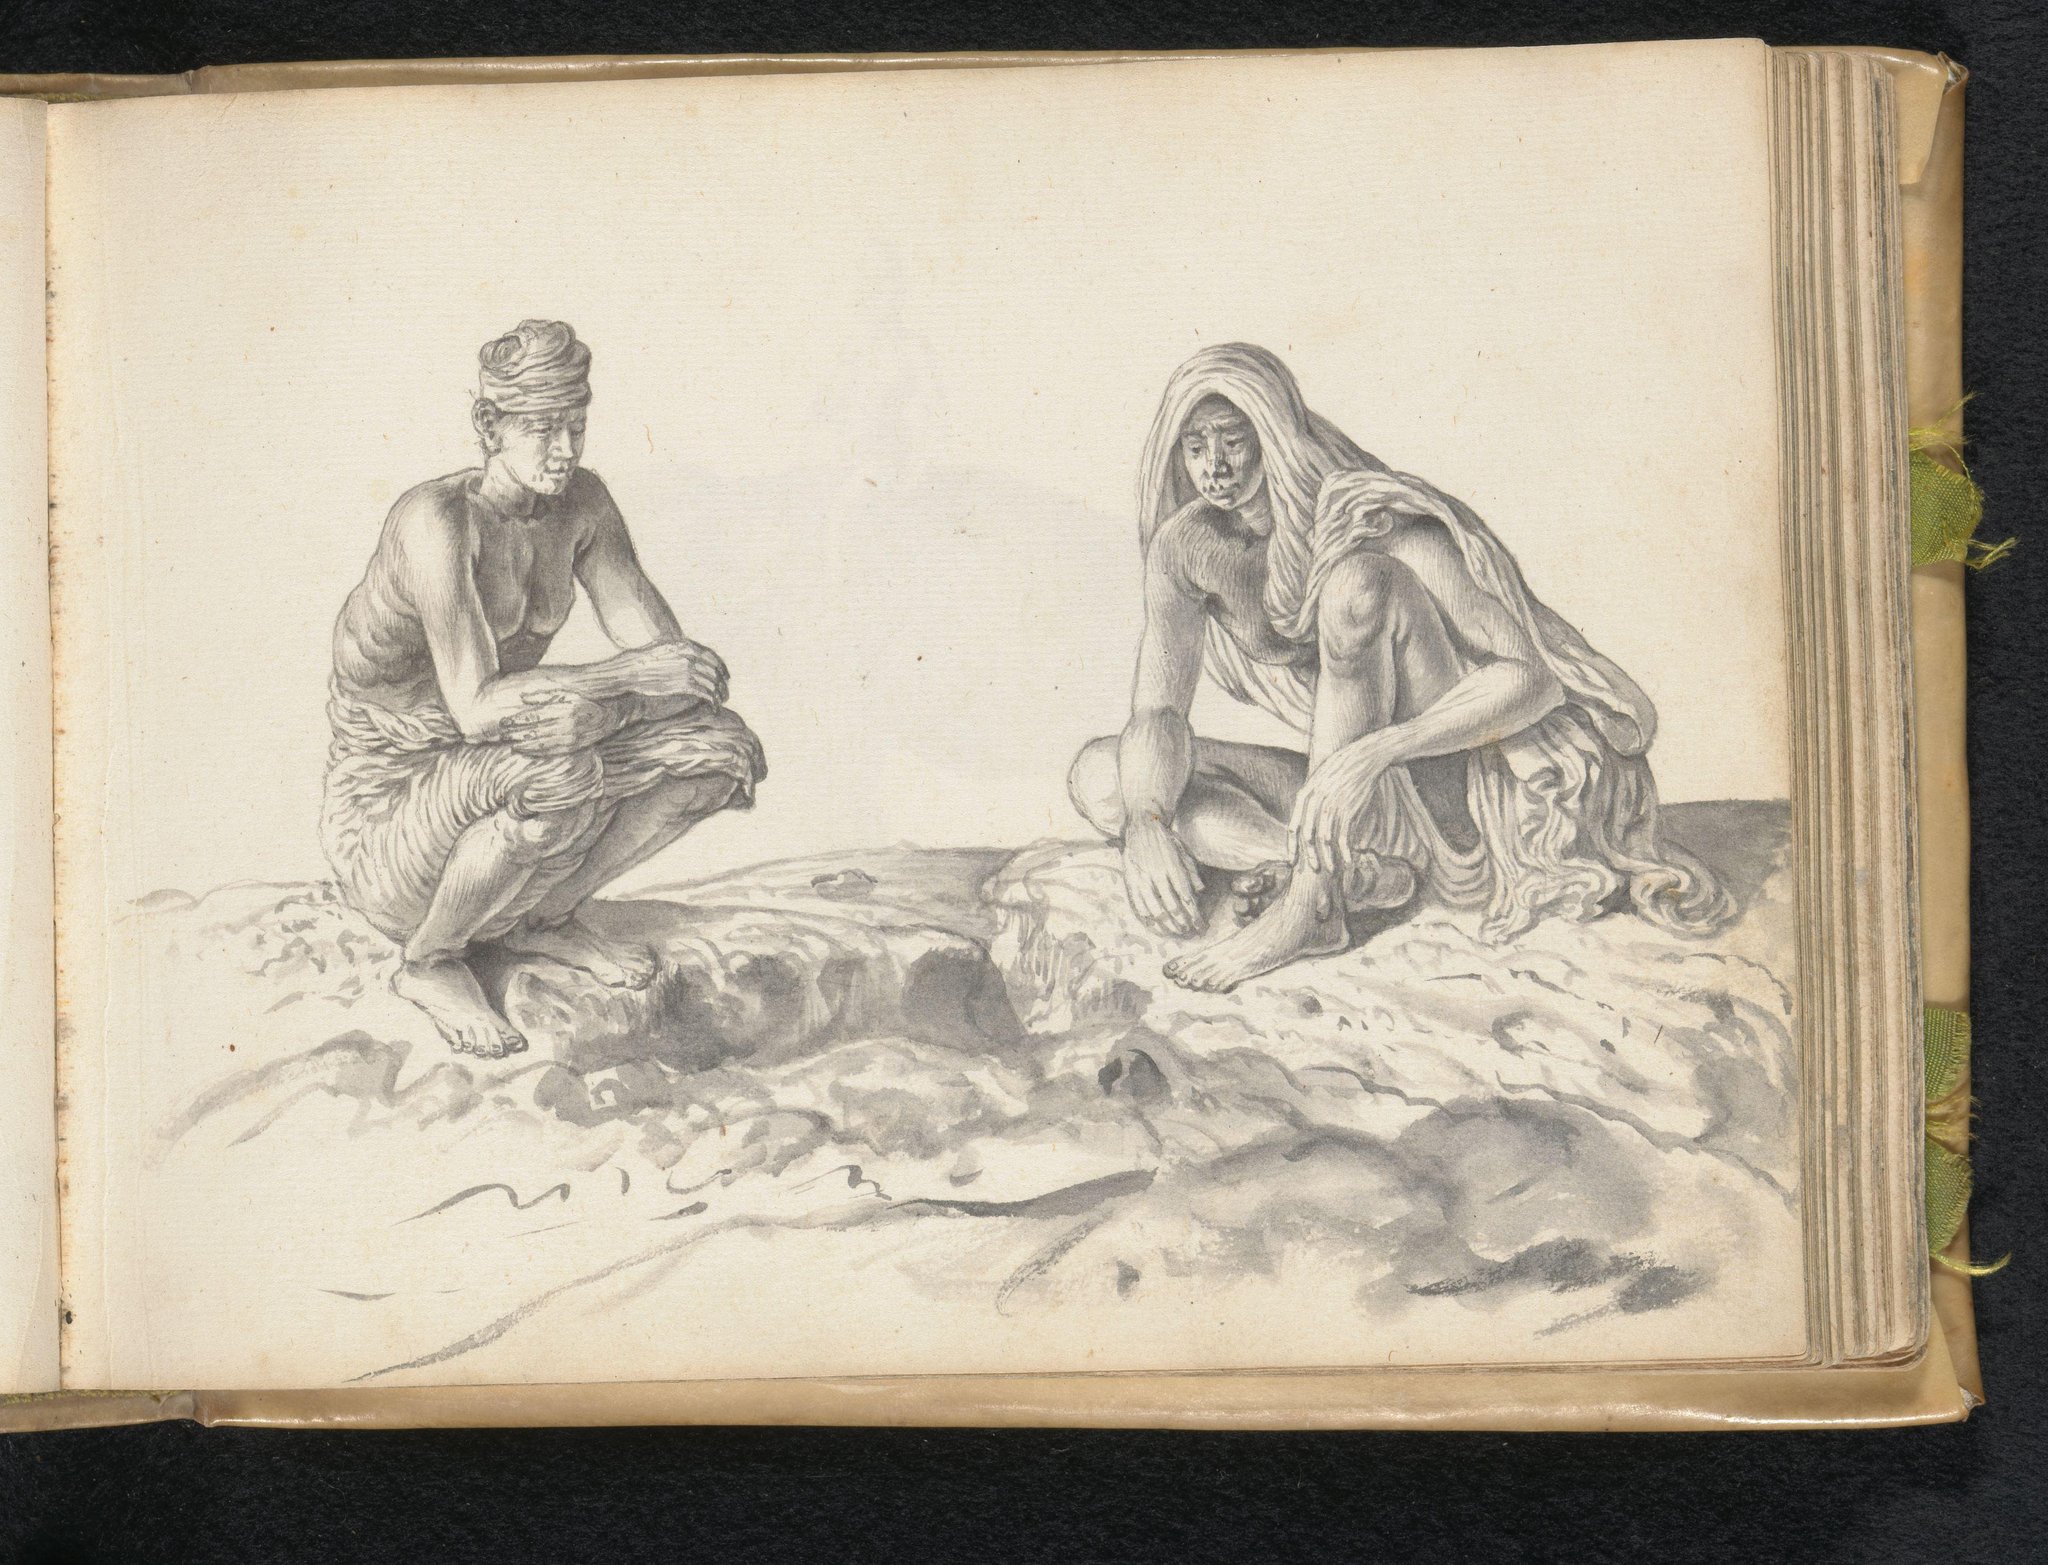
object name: sketchbook leaf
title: Two labourers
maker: esaias boursse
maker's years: 1631-1672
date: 1662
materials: ink, paper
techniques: brush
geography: sri lanka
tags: 41d232(...) skirt (lungi), head-gear (with name), sitting cross-legged, as tailor at work, asiatic races and peoples: indians, sri lanka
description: Buiten op een oneffen terrein zitten twee mannen op de grond. Hij draagt een heupkleed (veshti, lungi) tot op knieën; het bovenlijf is onbedekt. Zijn over elkaar gevouwen armen liggen op zijn knieën. Om het hoofd is een doek gewikkeld. De man rechts draagt een hoog opgeschorte heupkleed waarvan een deel over zijn linkerheup hangt, laat de benen bloot. Over het hoofd is een doek (chadar) geslagen die rug en linkerschouder bedekt. De man zit op de grond als in kleermakerszit. De armen liggen elk ontspannen op en om een knie. De mannen zijn waarschijnlijk afkomstig van Zuid-India en in Colombo te werk gesteld in de wederopbouw. Blad 42 uit een schetsboek met 117 bladen.